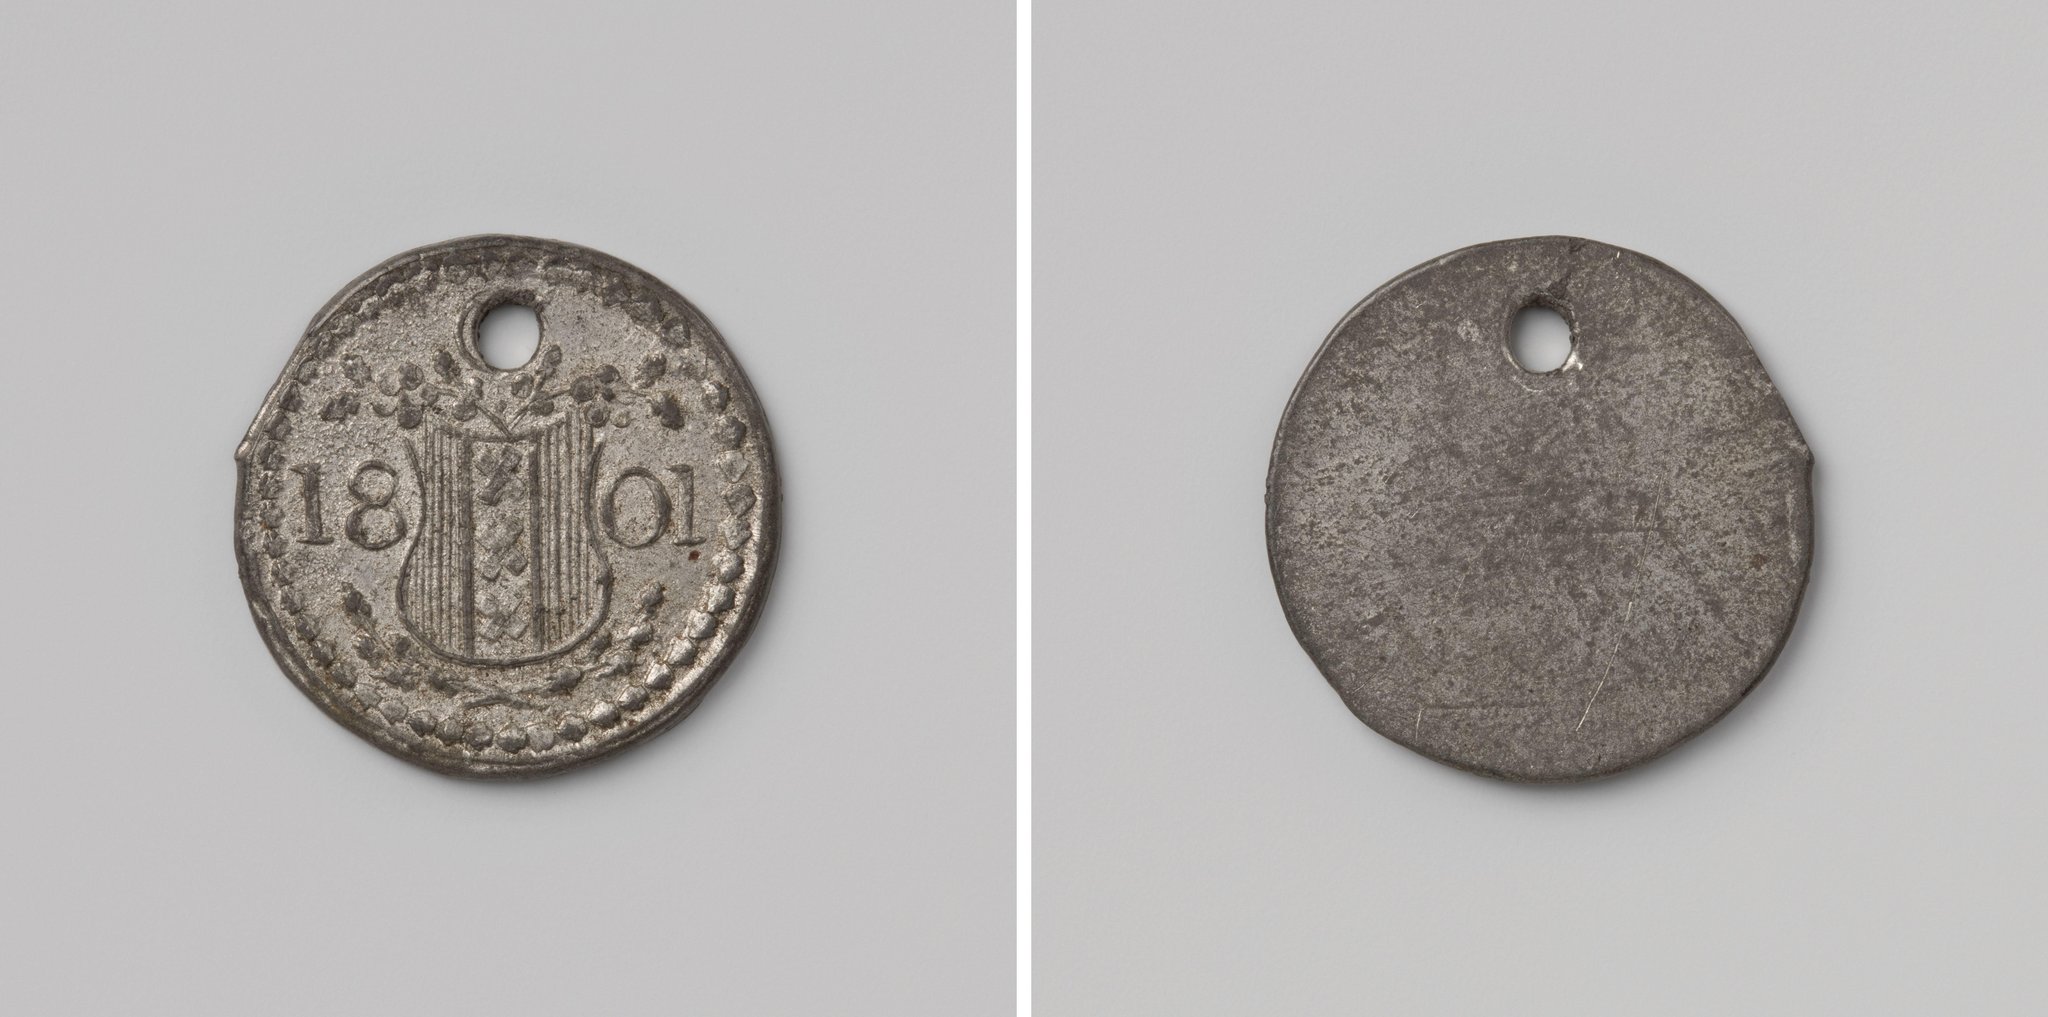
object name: tax token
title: Aalmoezeniersweeshuis te Amsterdam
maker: Anonymous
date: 1801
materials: tin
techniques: striking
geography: amsterdam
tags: amsterdam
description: eenzijdig loodje met gat erin. Voorzijde: wapenschild op twee gekruiste bladertakken tussen jaartal. Keerzijde: blanco